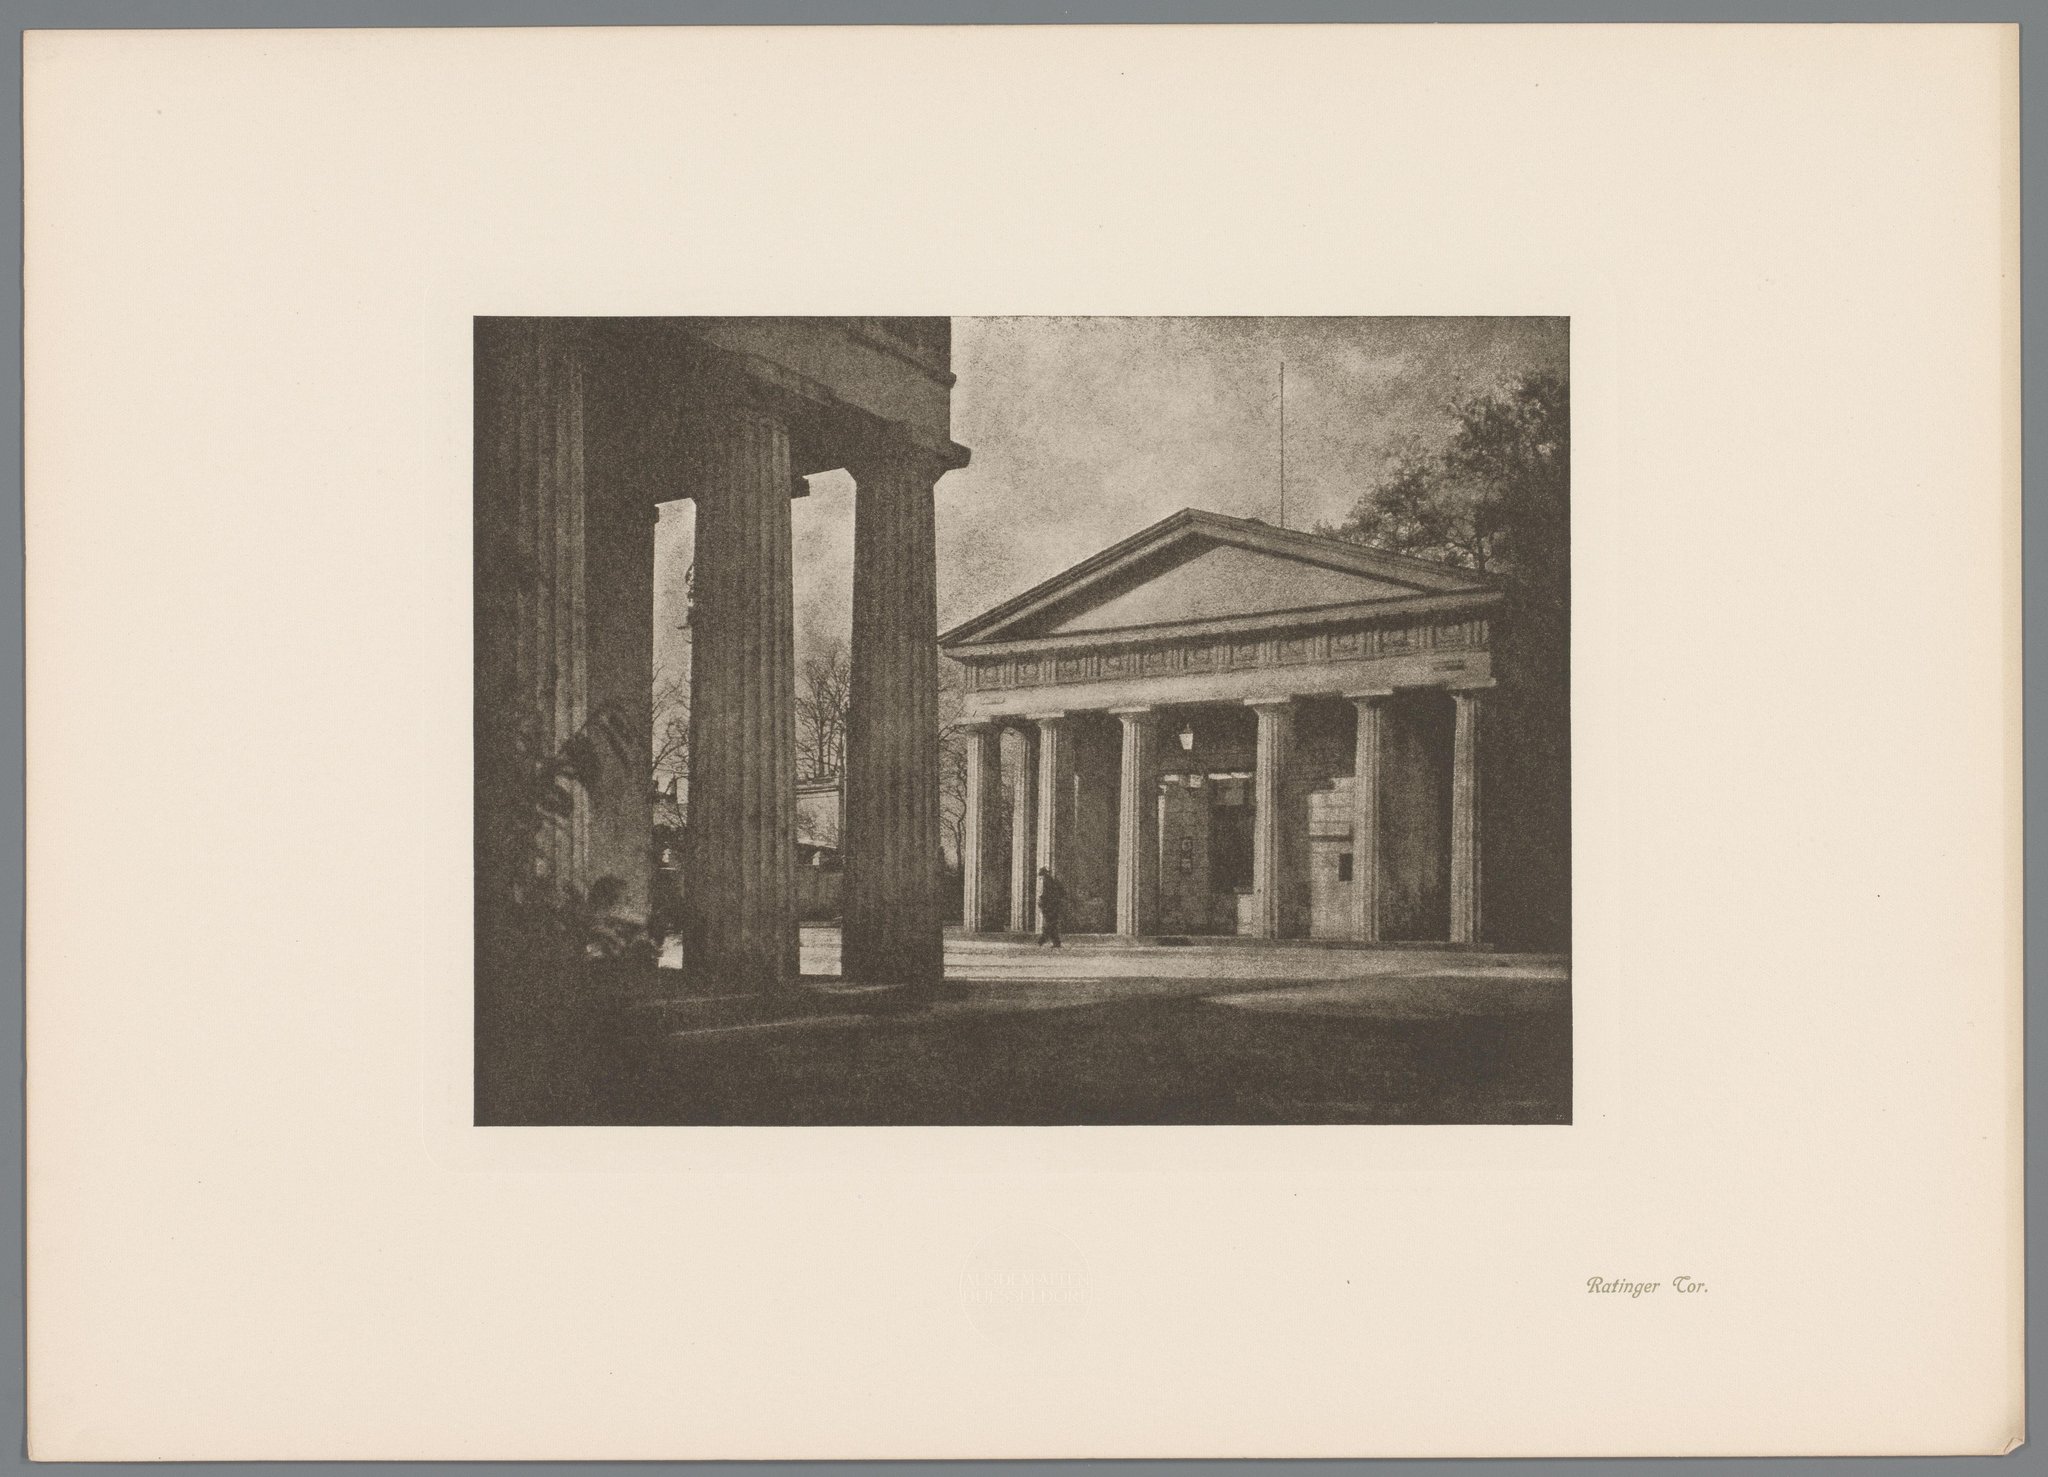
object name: photomechanical print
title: Reproductie van een gomdruk van de Ratinger Tor in Düsseldorf door Erwin Quedenfeldt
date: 1902-1907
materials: paper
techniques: autotype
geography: dusseldorf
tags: city-gate